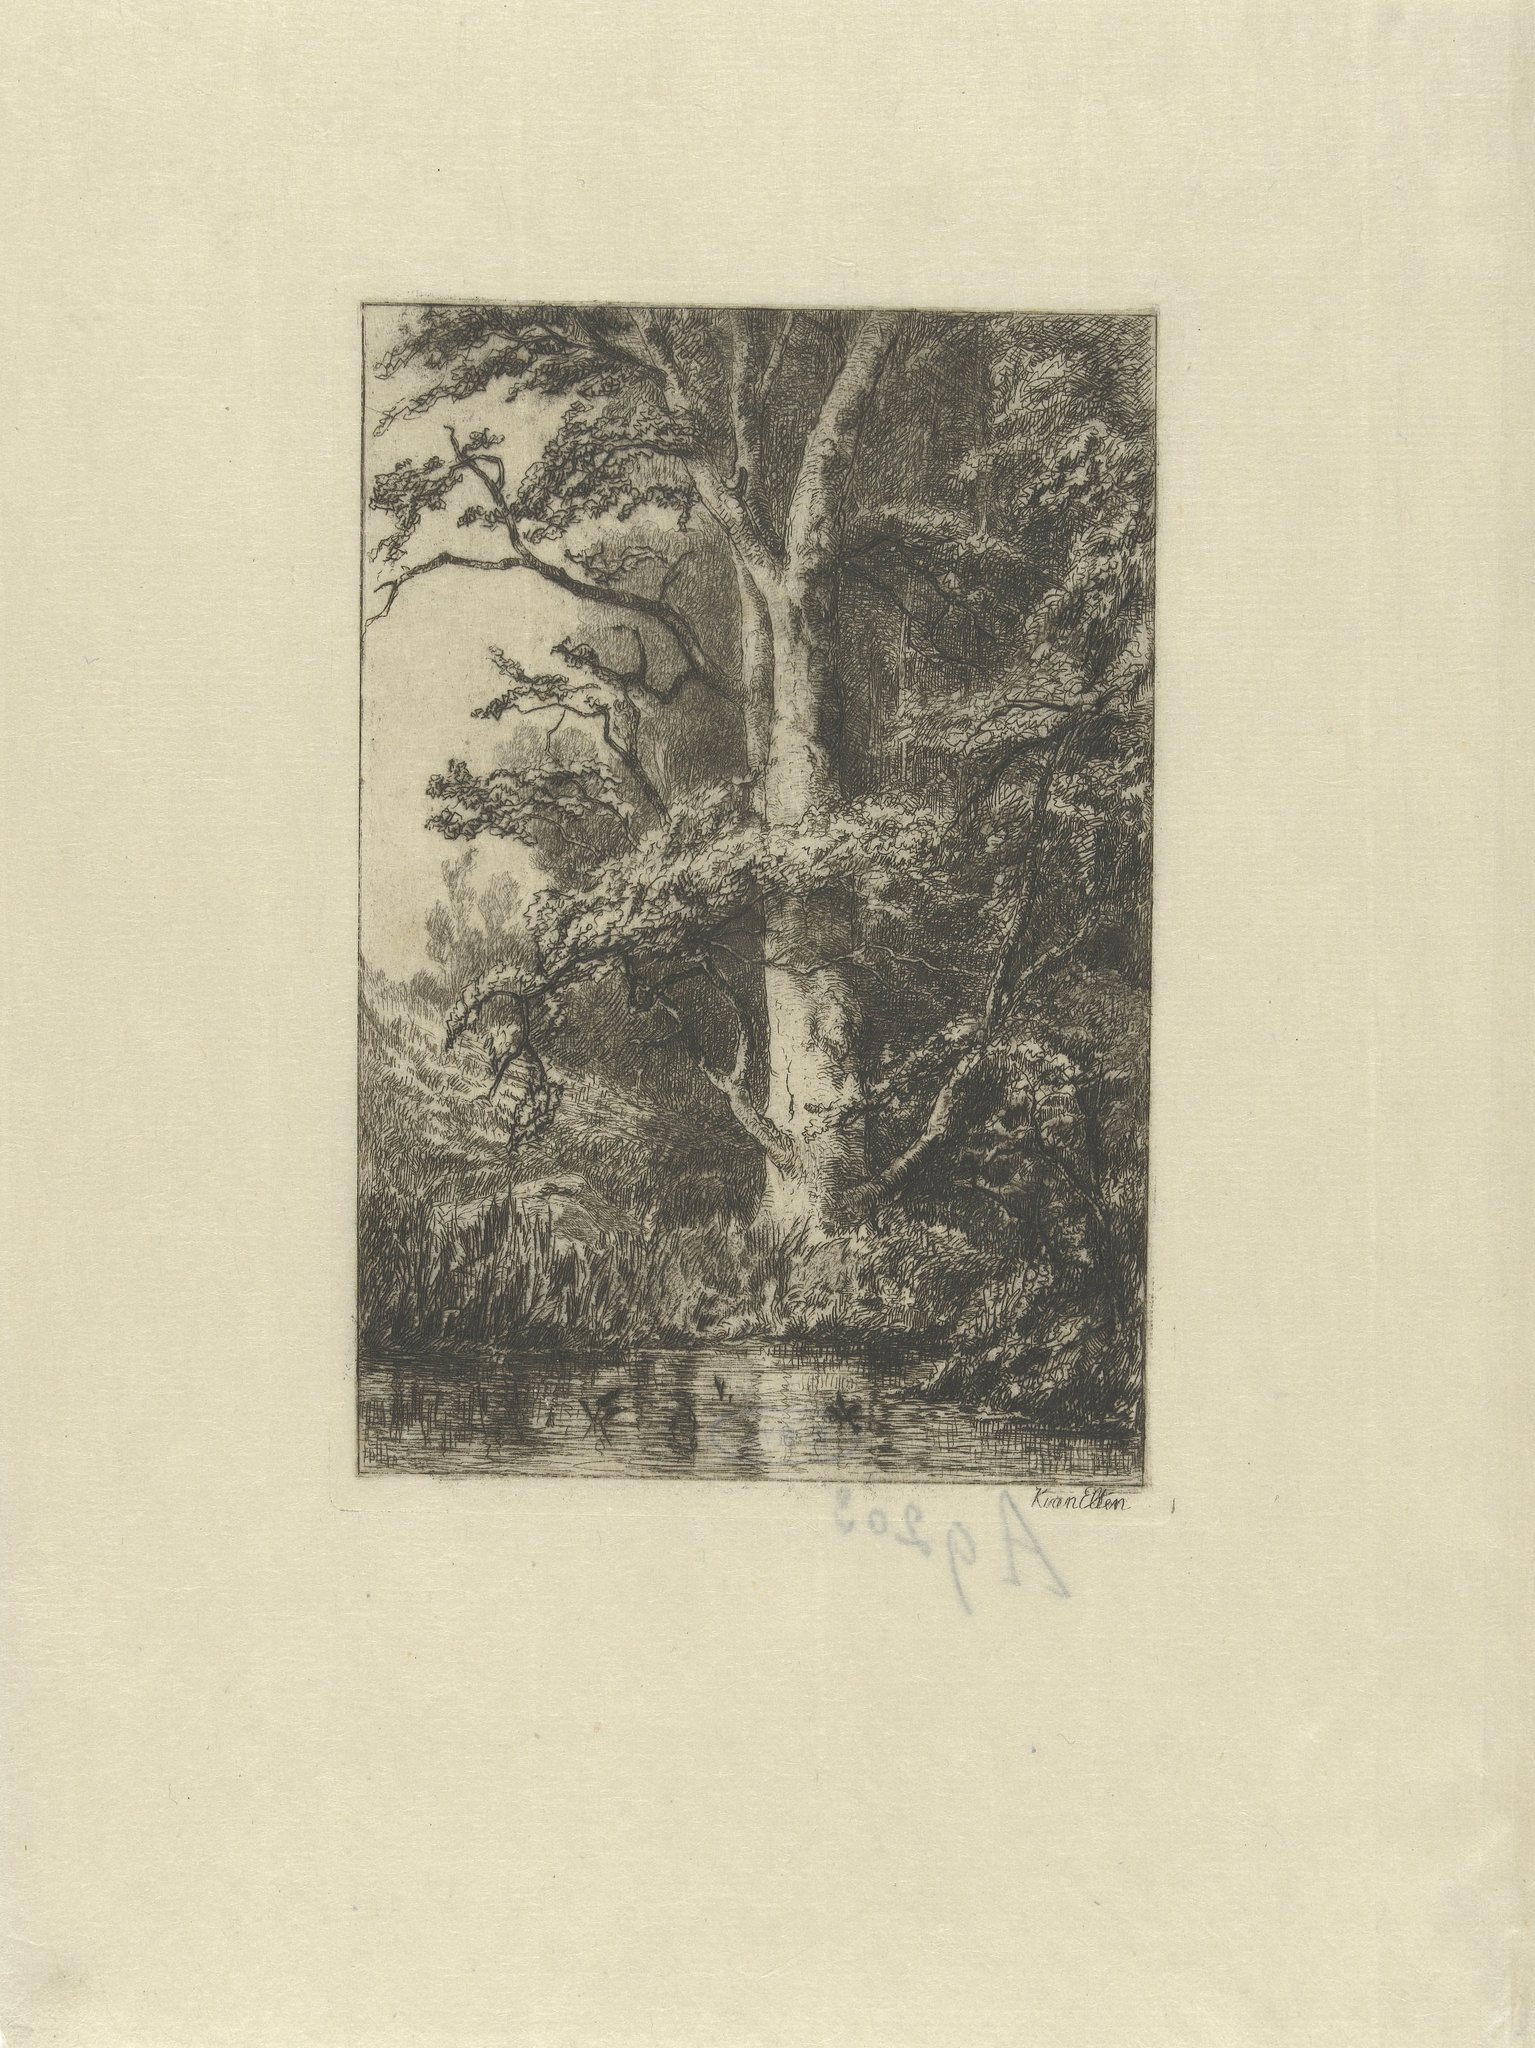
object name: print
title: Beech Tree Holland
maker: hendrik dirk kruseman van elten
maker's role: draughtsman, print maker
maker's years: 1829-1904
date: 1880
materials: paper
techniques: drypoint, etching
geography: netherlands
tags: trees, pond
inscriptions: collector's mark: Lugt 2228